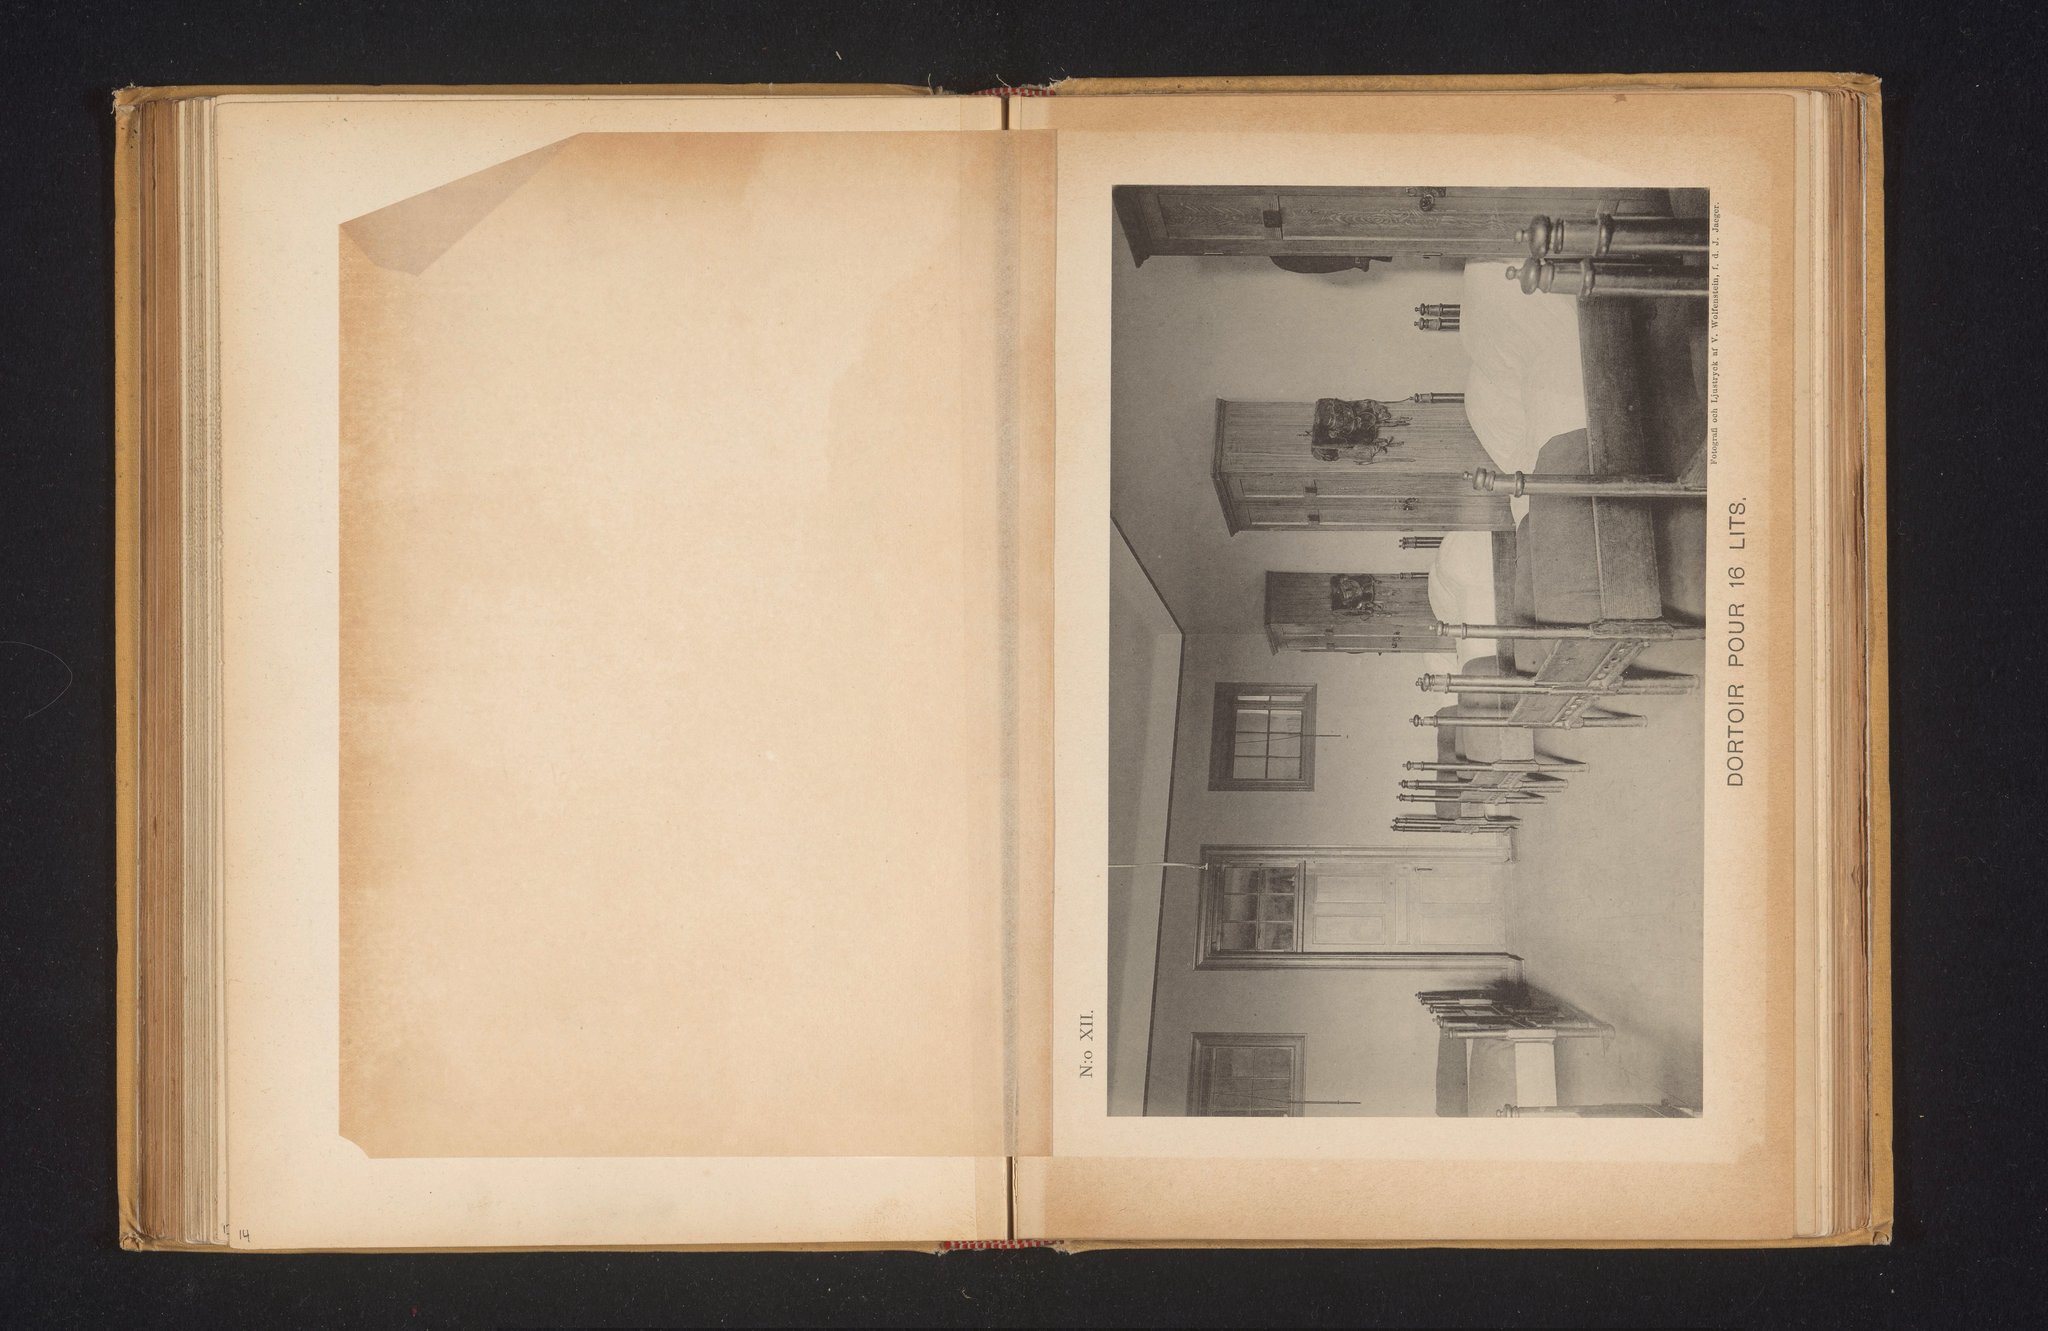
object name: photomechanical print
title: Slaapzaal in een kazerne van de Svea livgarde in Stockholm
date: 1888-1891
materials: paper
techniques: photograph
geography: stockholm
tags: bed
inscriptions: number: ‘N:o XII.’